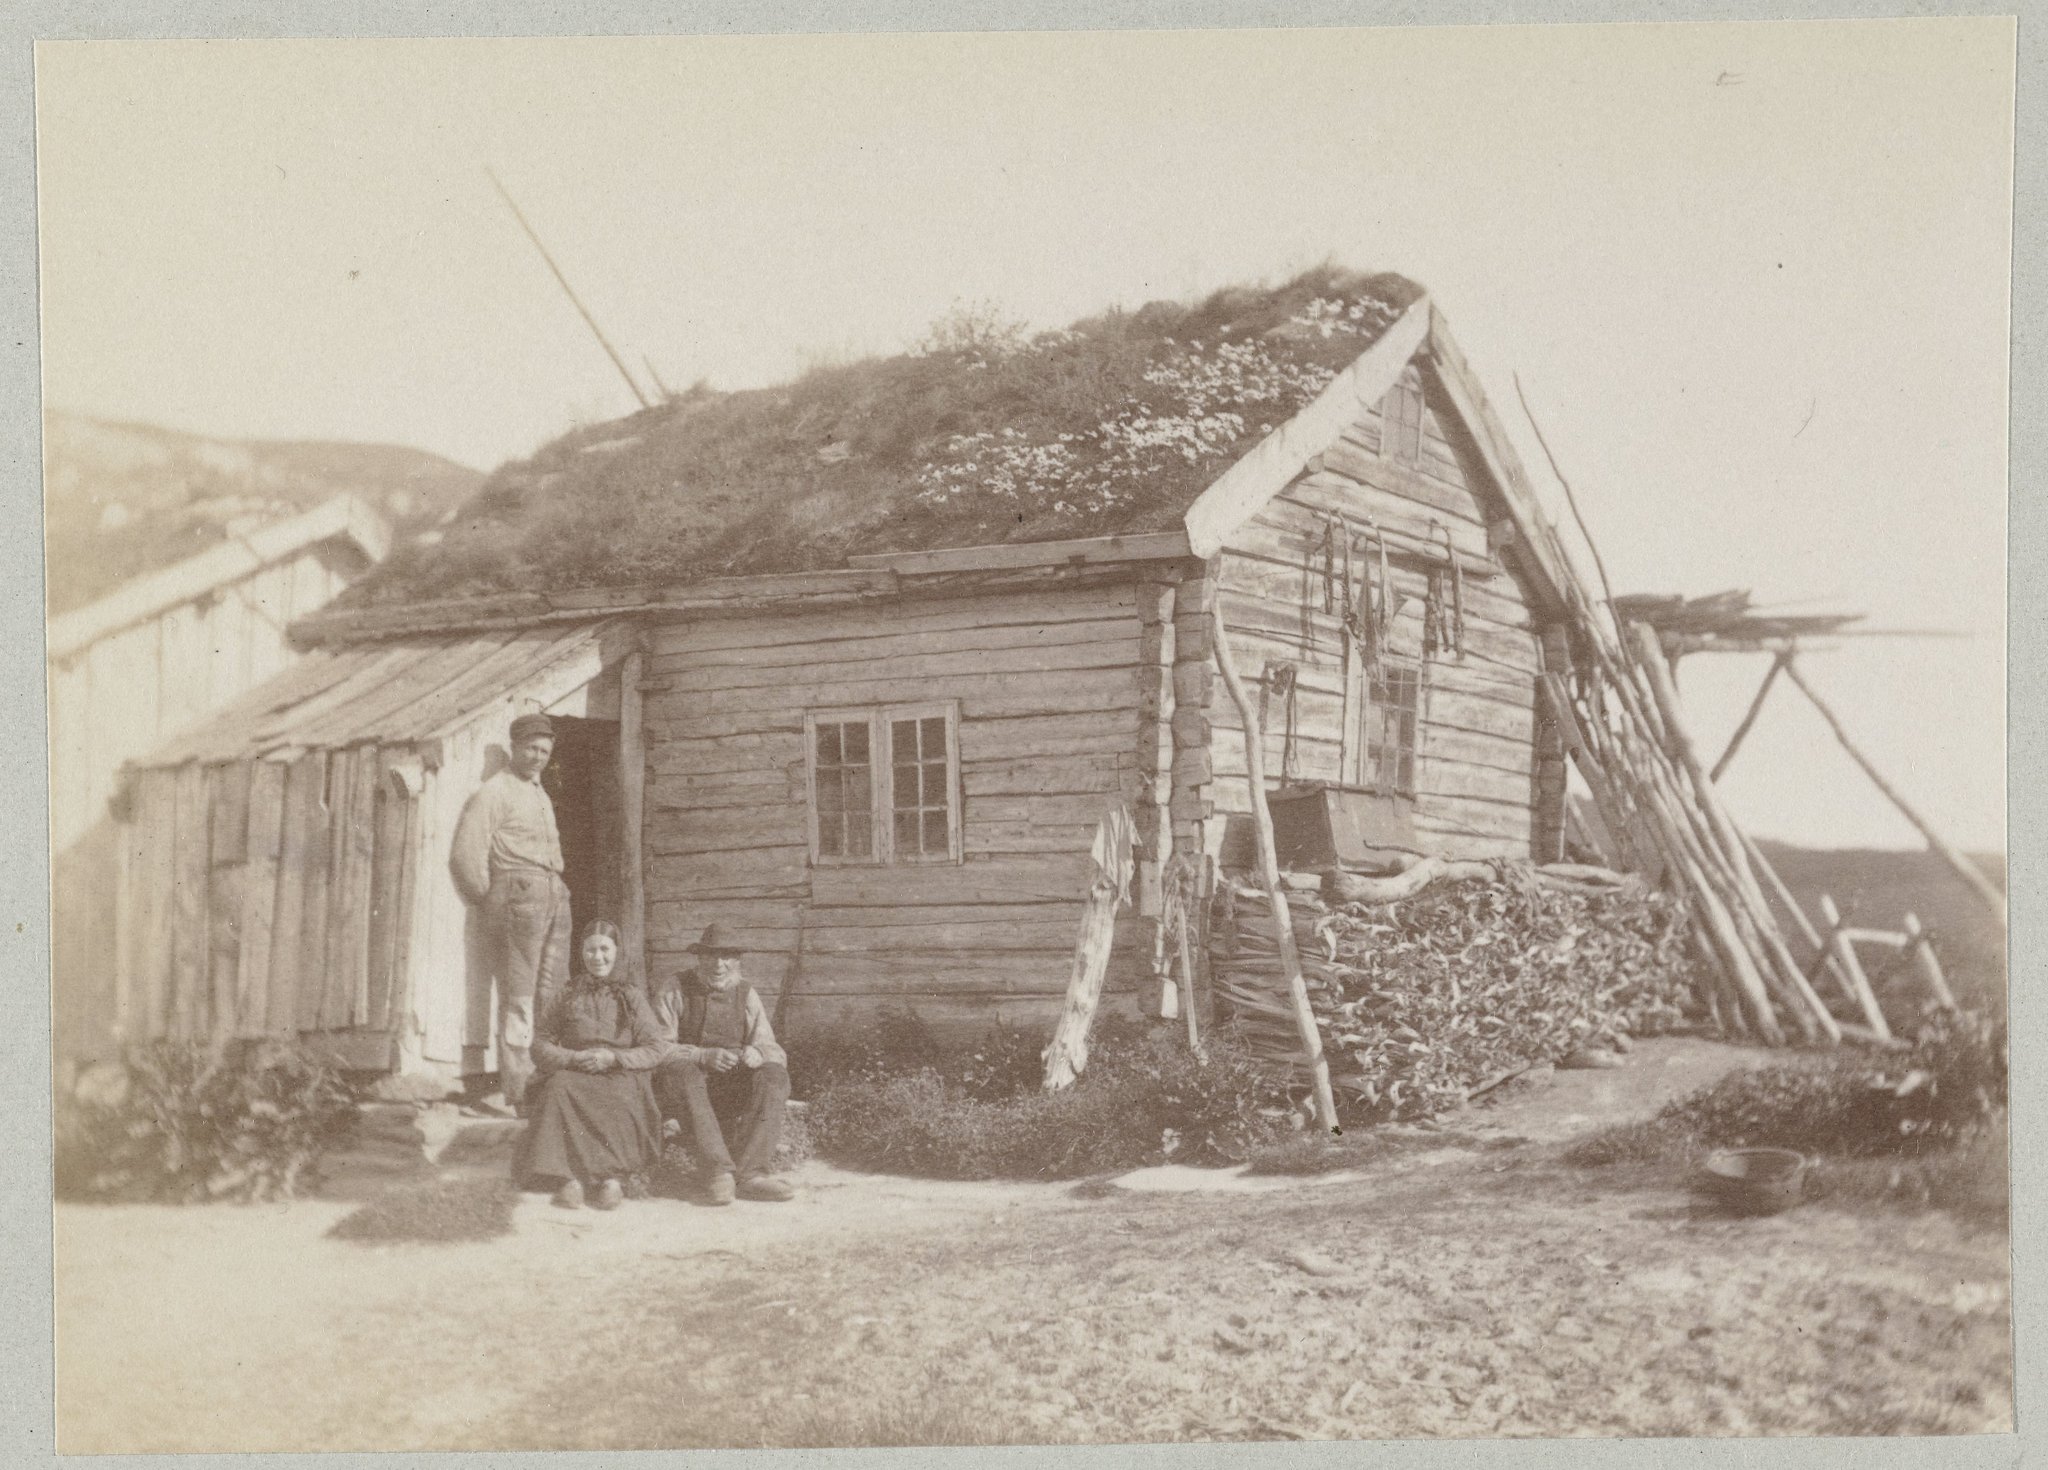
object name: photograph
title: Gezin voor hun houten woning met dakbegroeiing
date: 1807-1889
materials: cardboard, paper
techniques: albumen print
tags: wilhelm ii (keizer van duitsland), norway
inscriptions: number: ‘32’